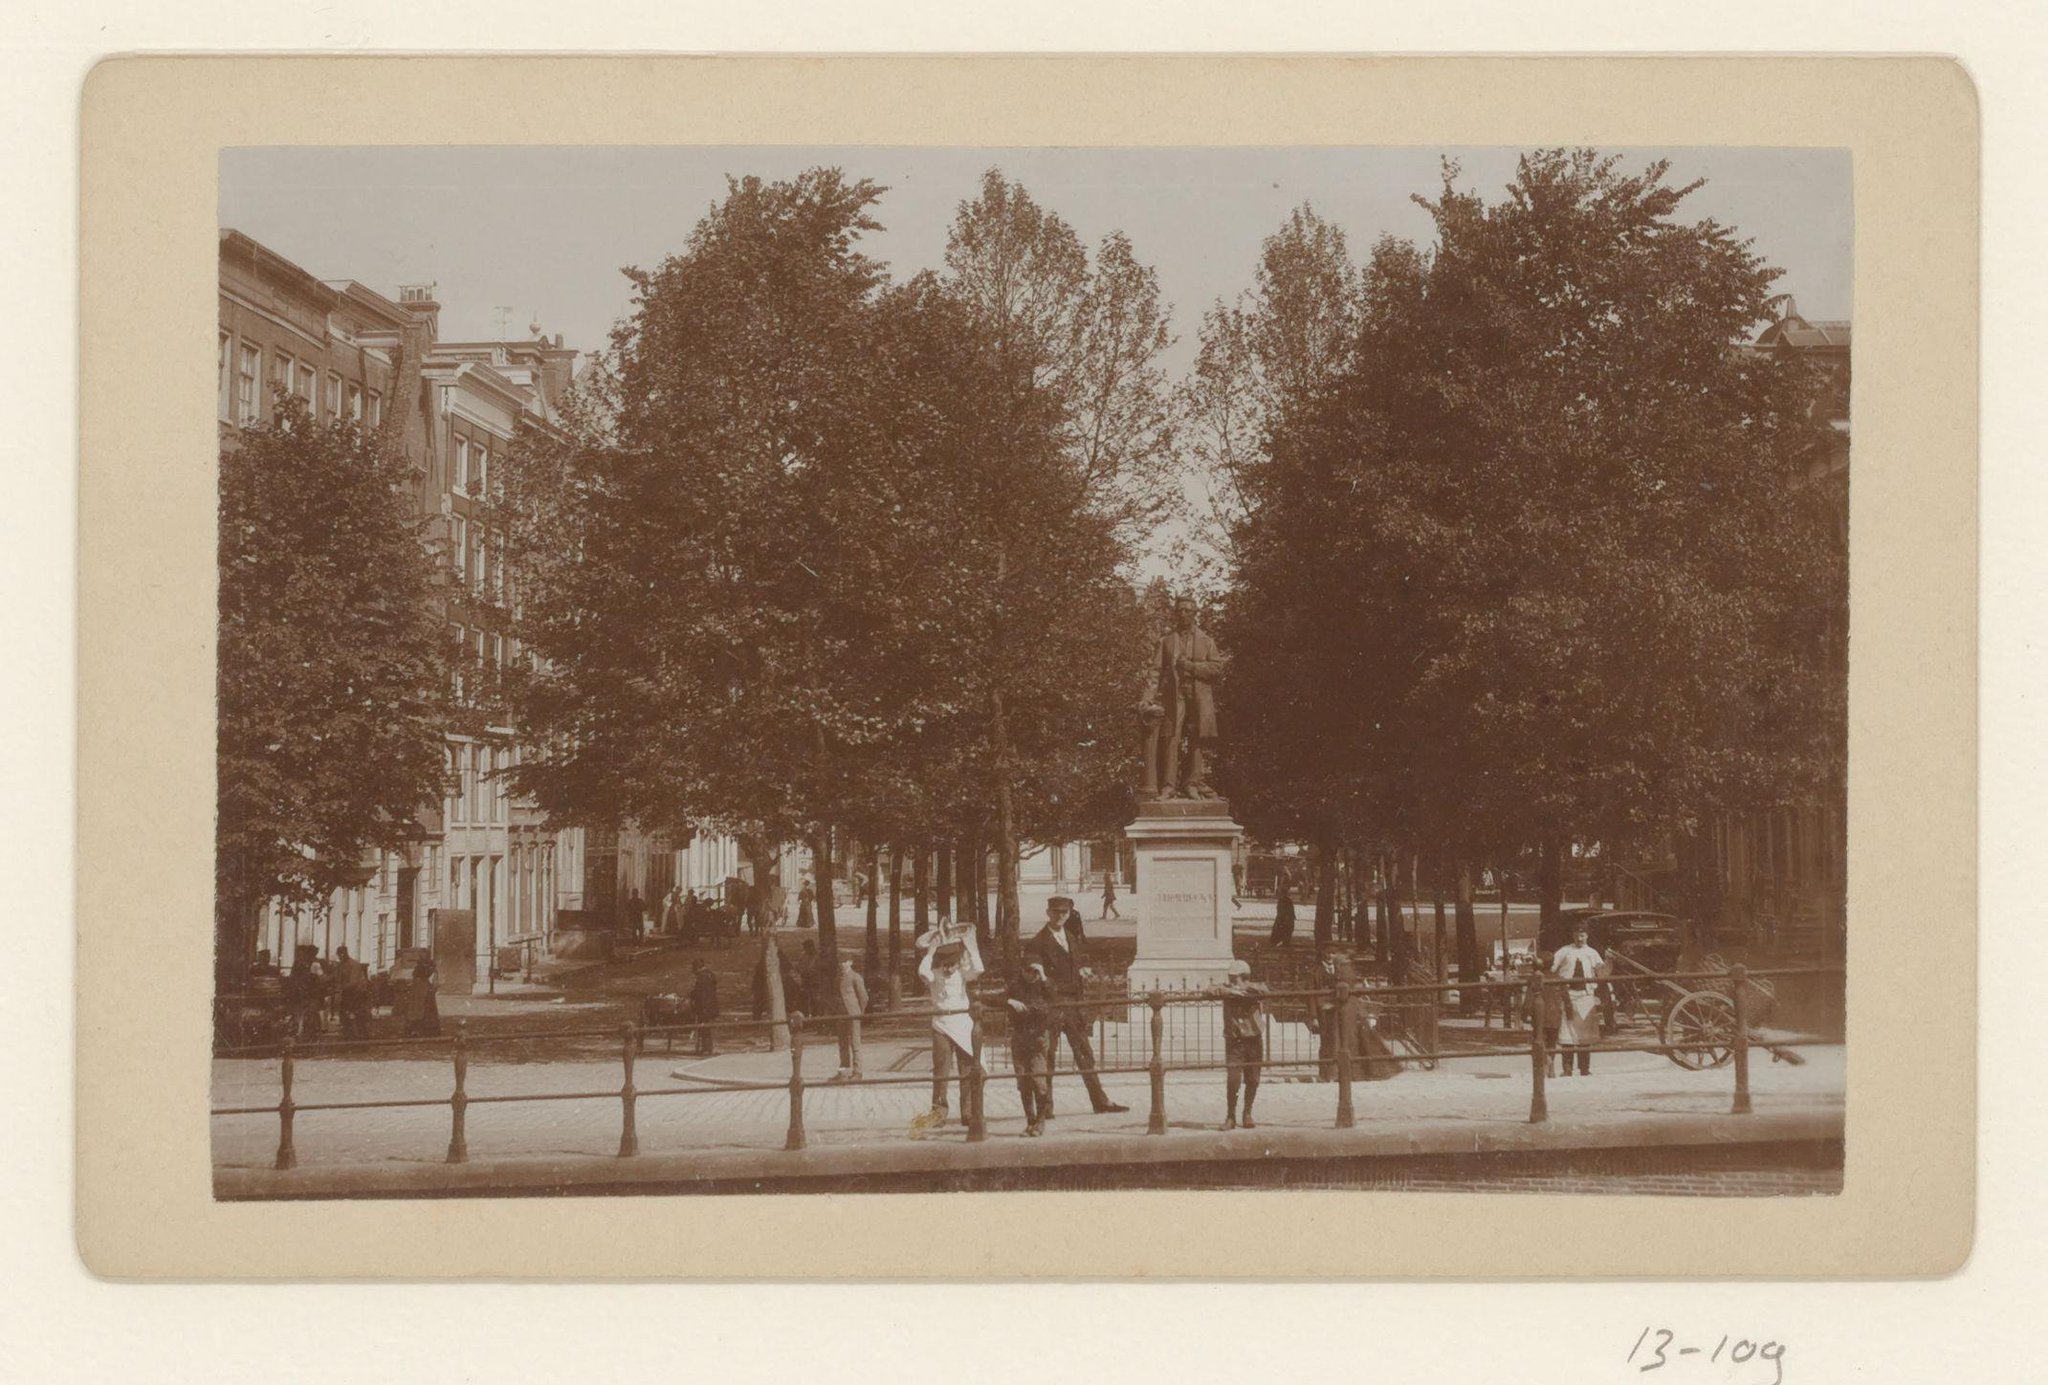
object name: cabinet photograph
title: Gezicht op het Thorbeckeplein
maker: Anonymous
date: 1876-1940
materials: paper, cardboard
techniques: collodion silver print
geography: amsterdam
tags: square, place, circus, etc., city-view in general; 'veduta', monument, statue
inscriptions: collector's mark: ‘13,109’ Lugt 1641b, inscription: ‘No 24 Thorbeckeplein’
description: Onderwerpsrubriek binnen de Atlas Amsterdam: Taanstraat, Teertuinen (Nieuwe), Thorbeckeplein, Tolhuis, Tuinstraat (Kromme), Turfmarkt (Oude), Uilenburgergracht, Uilenburgerstraat, Utrechtsestraat.